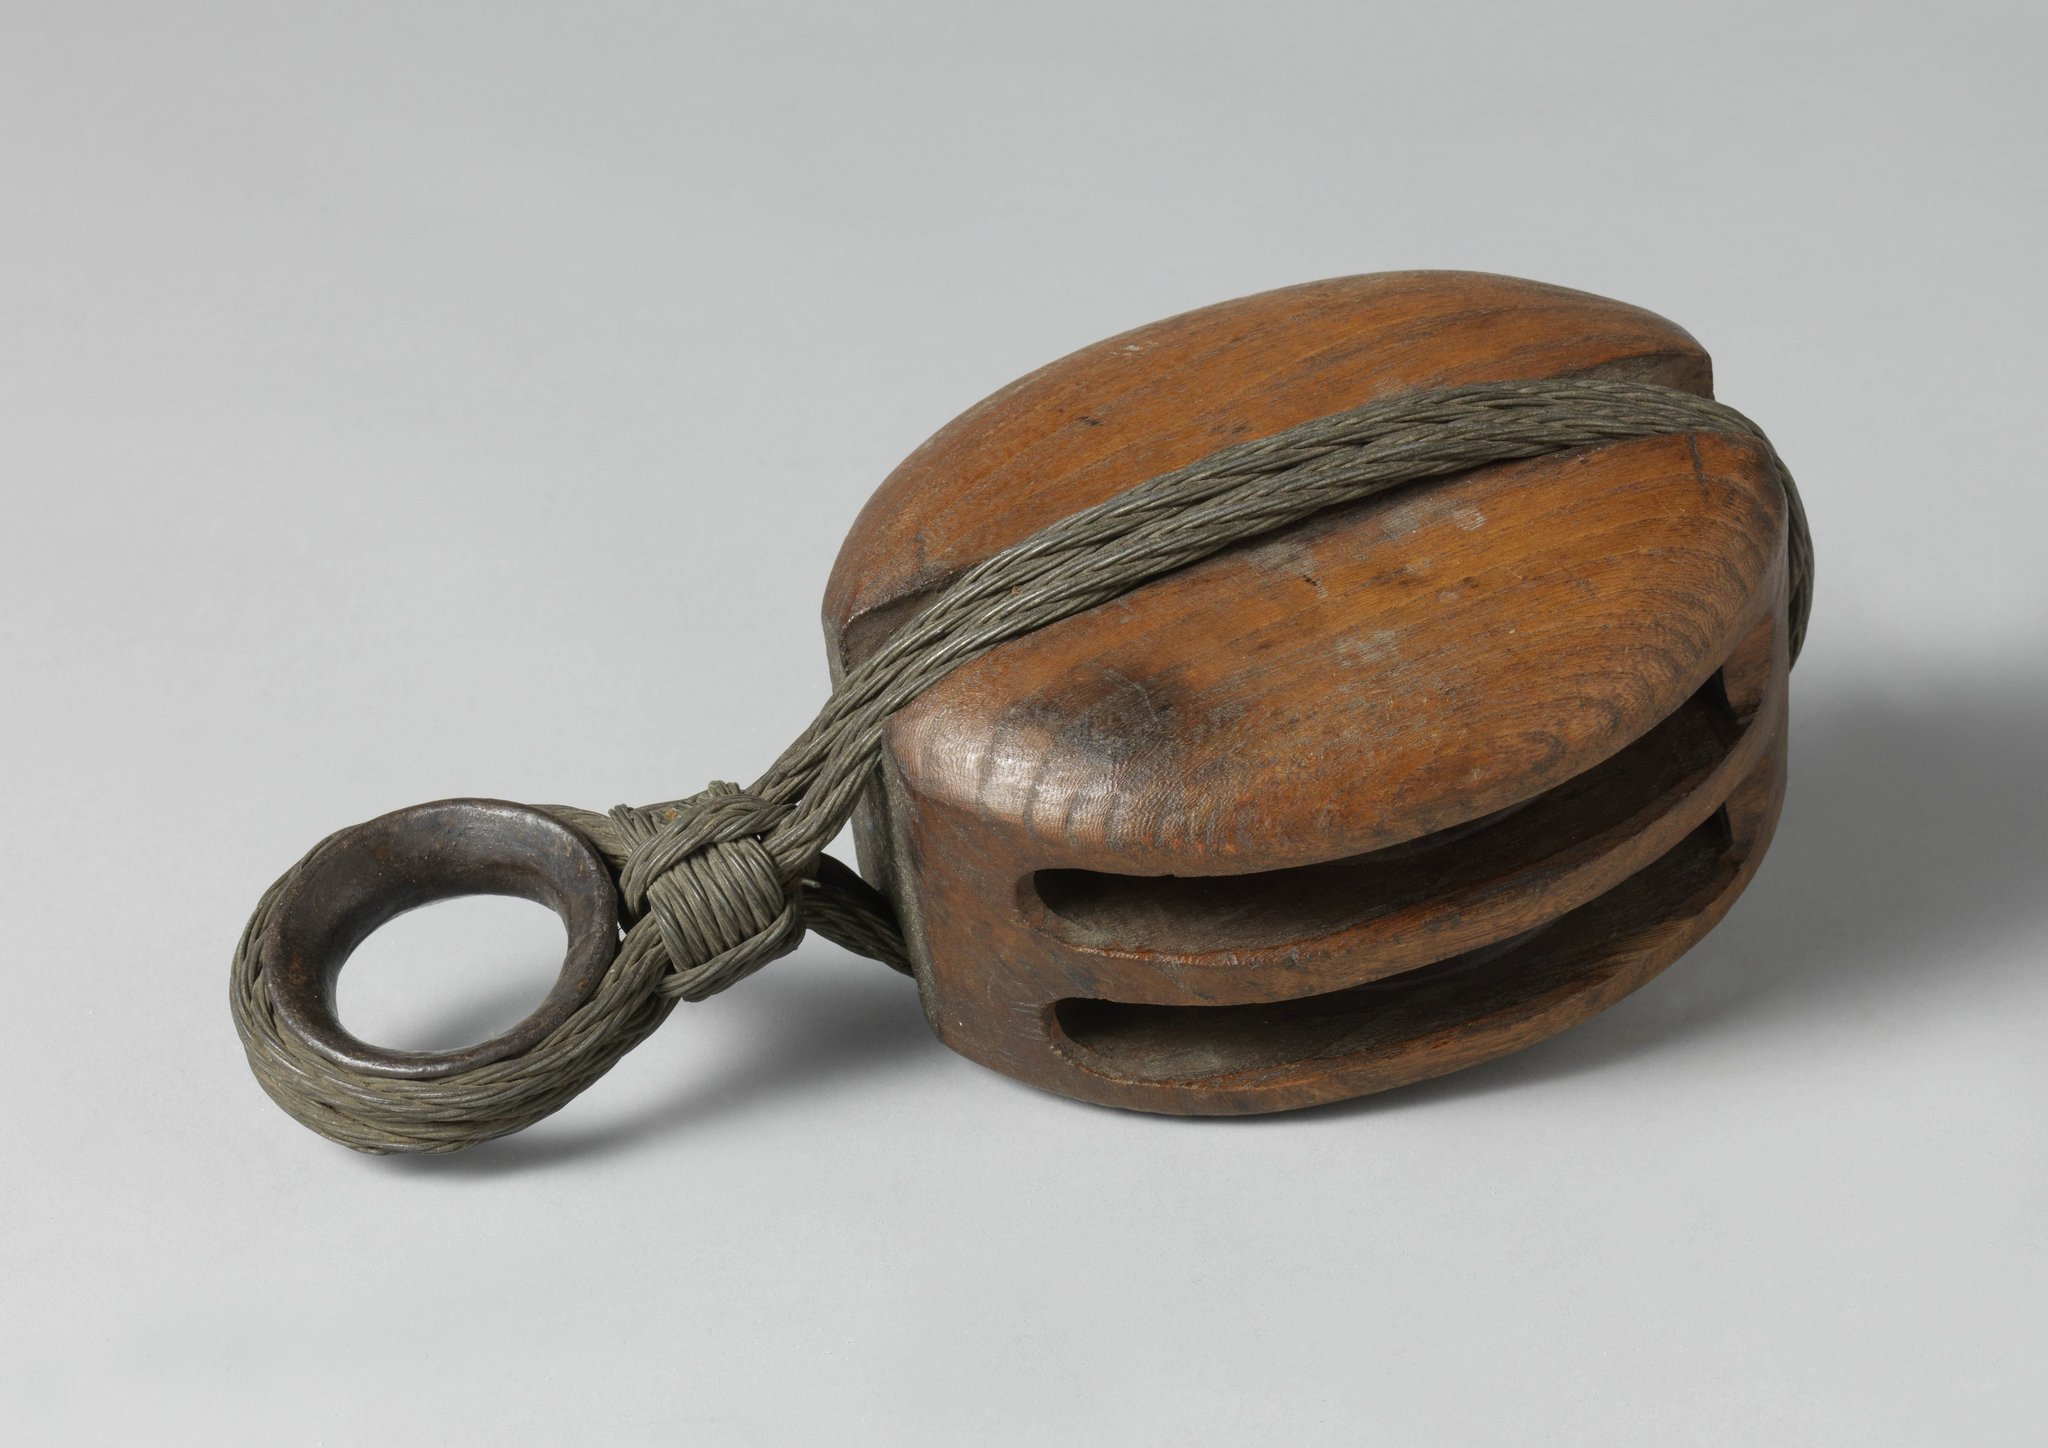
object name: block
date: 1861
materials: iron, fiber, wood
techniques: galvanization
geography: flushing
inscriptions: inscription: ‘16 / 1861’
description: Tweeschijfs gordingblok volgens de voorschriften van 1865, met dubbele ijzerdraad strop en ijzerdraad bindsel en een ronde kous; 16 cm blok.